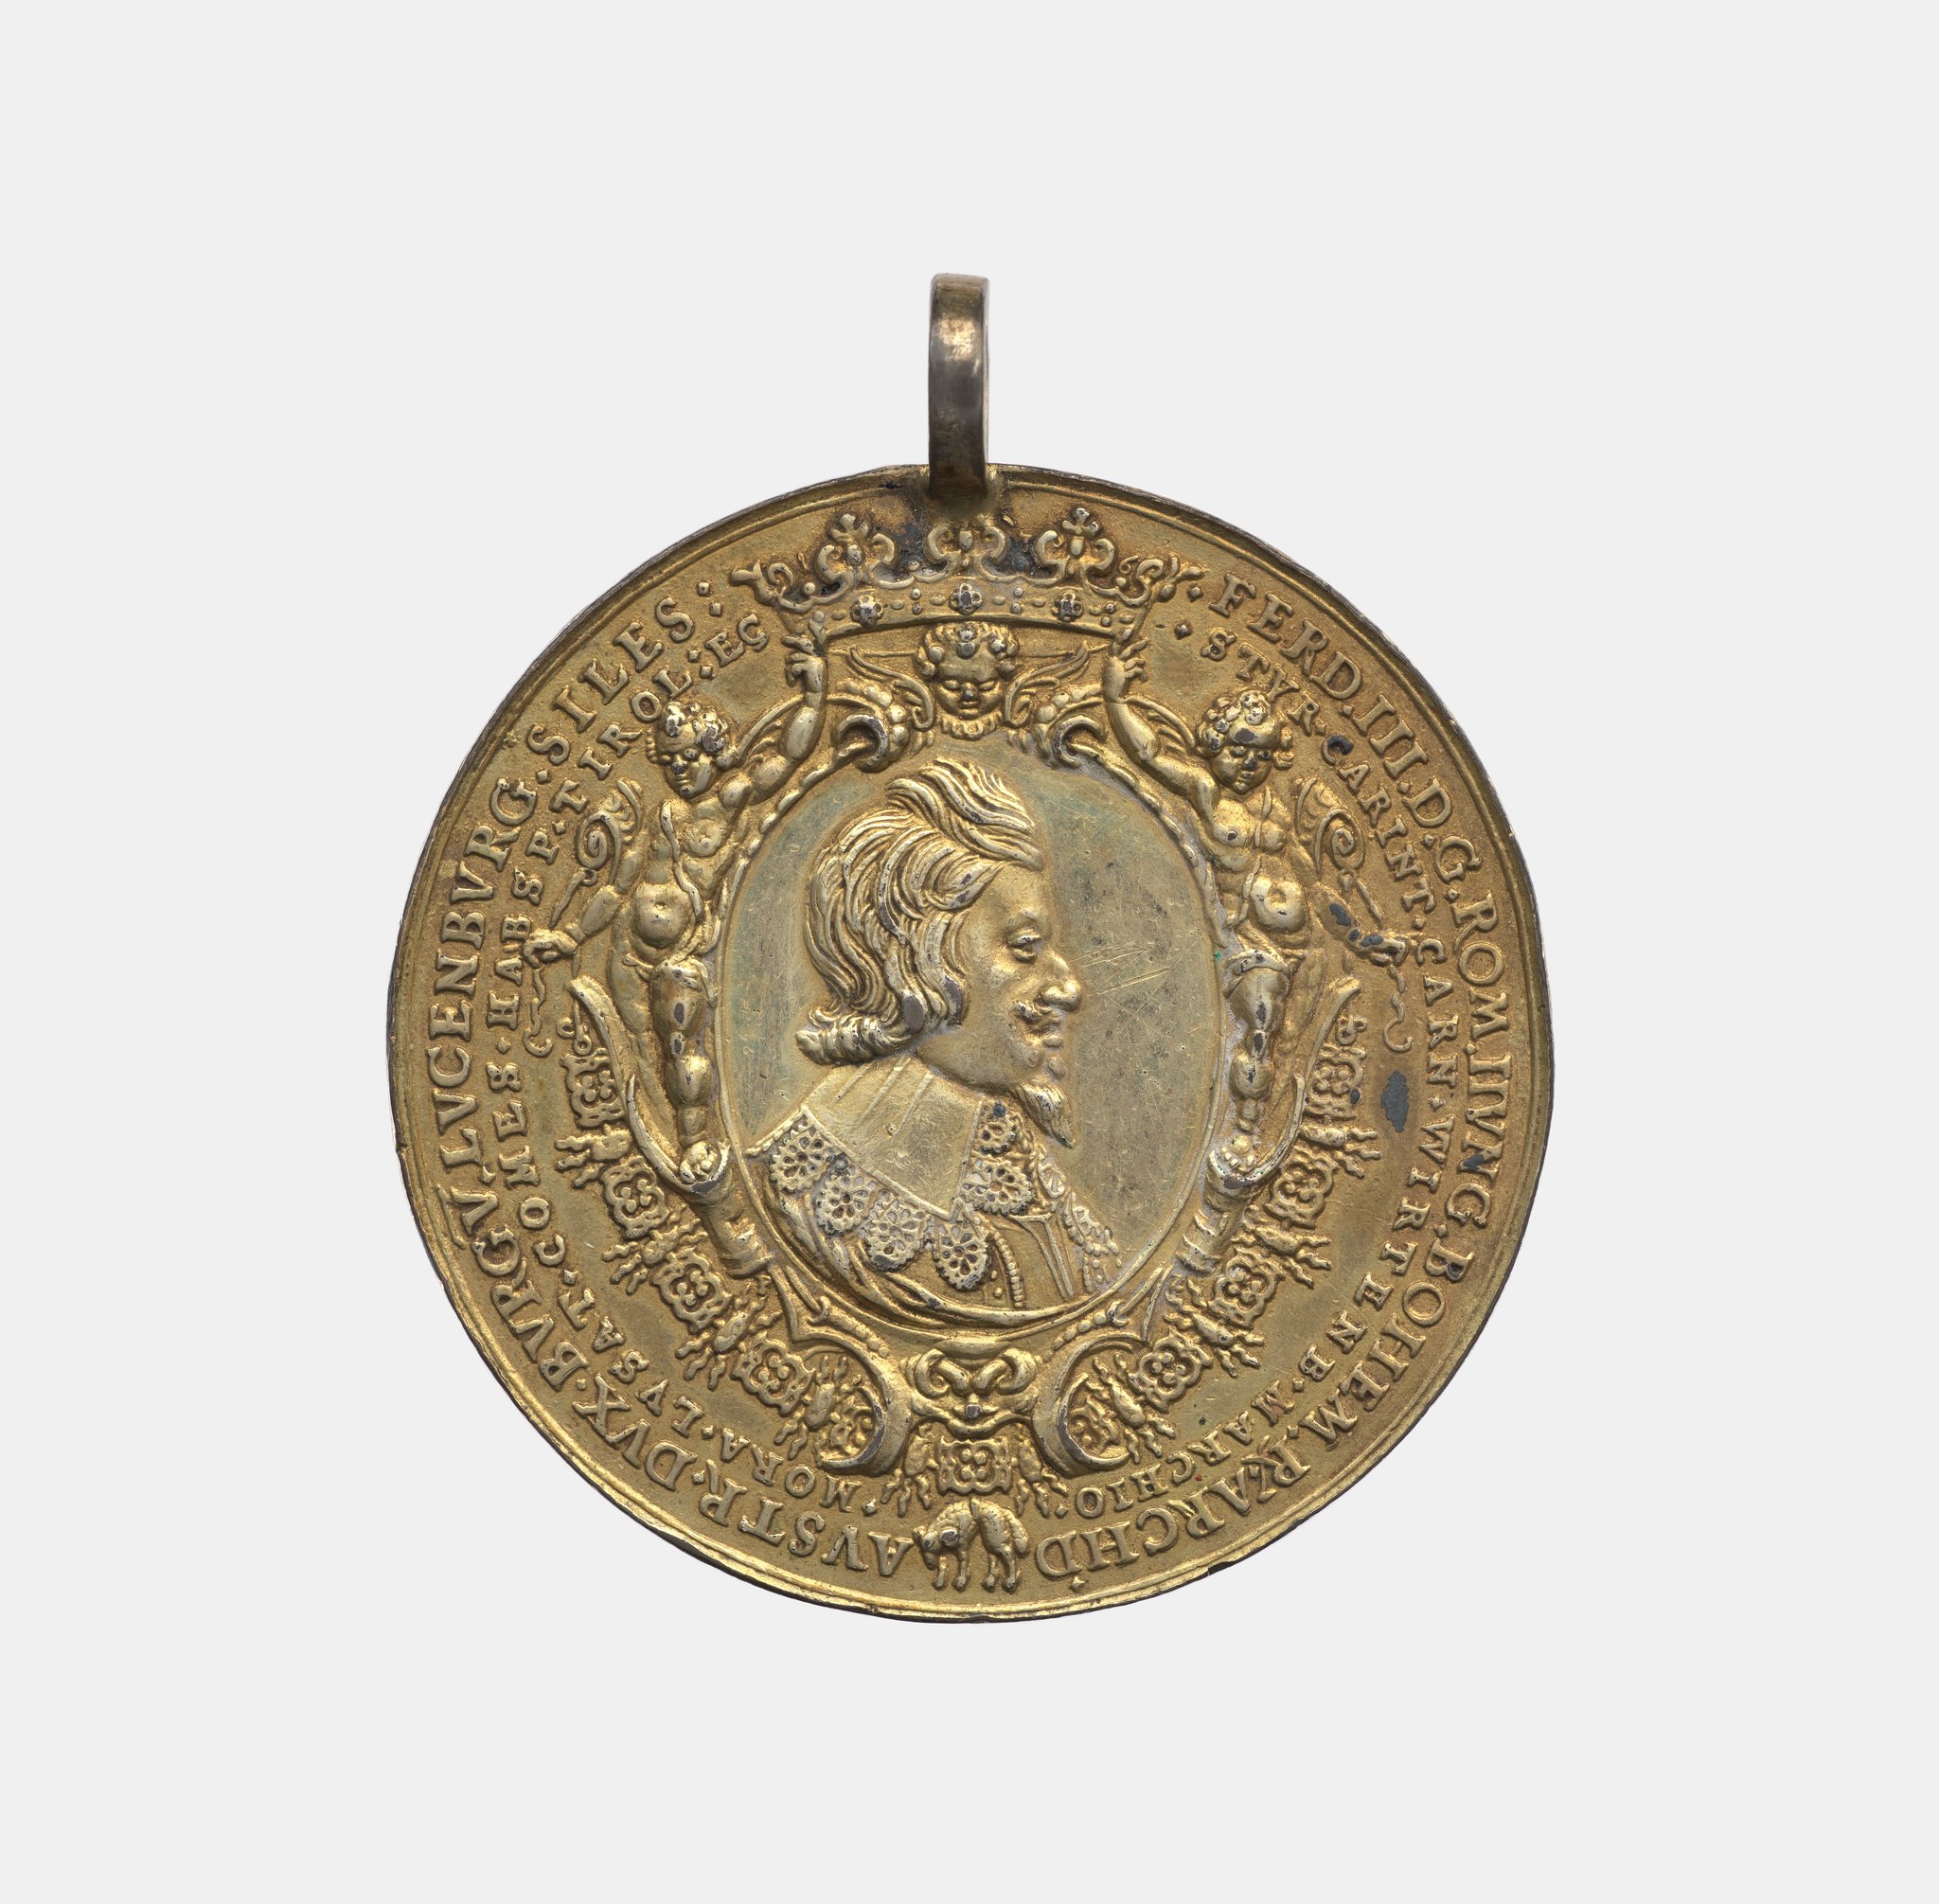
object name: medal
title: Ferdinand III of Hapsburg 1608-57, Emperor 1637-57, Victor of the Battle of Noerdlingen 1634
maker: Anonymous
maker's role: artist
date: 1629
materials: silver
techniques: gilding